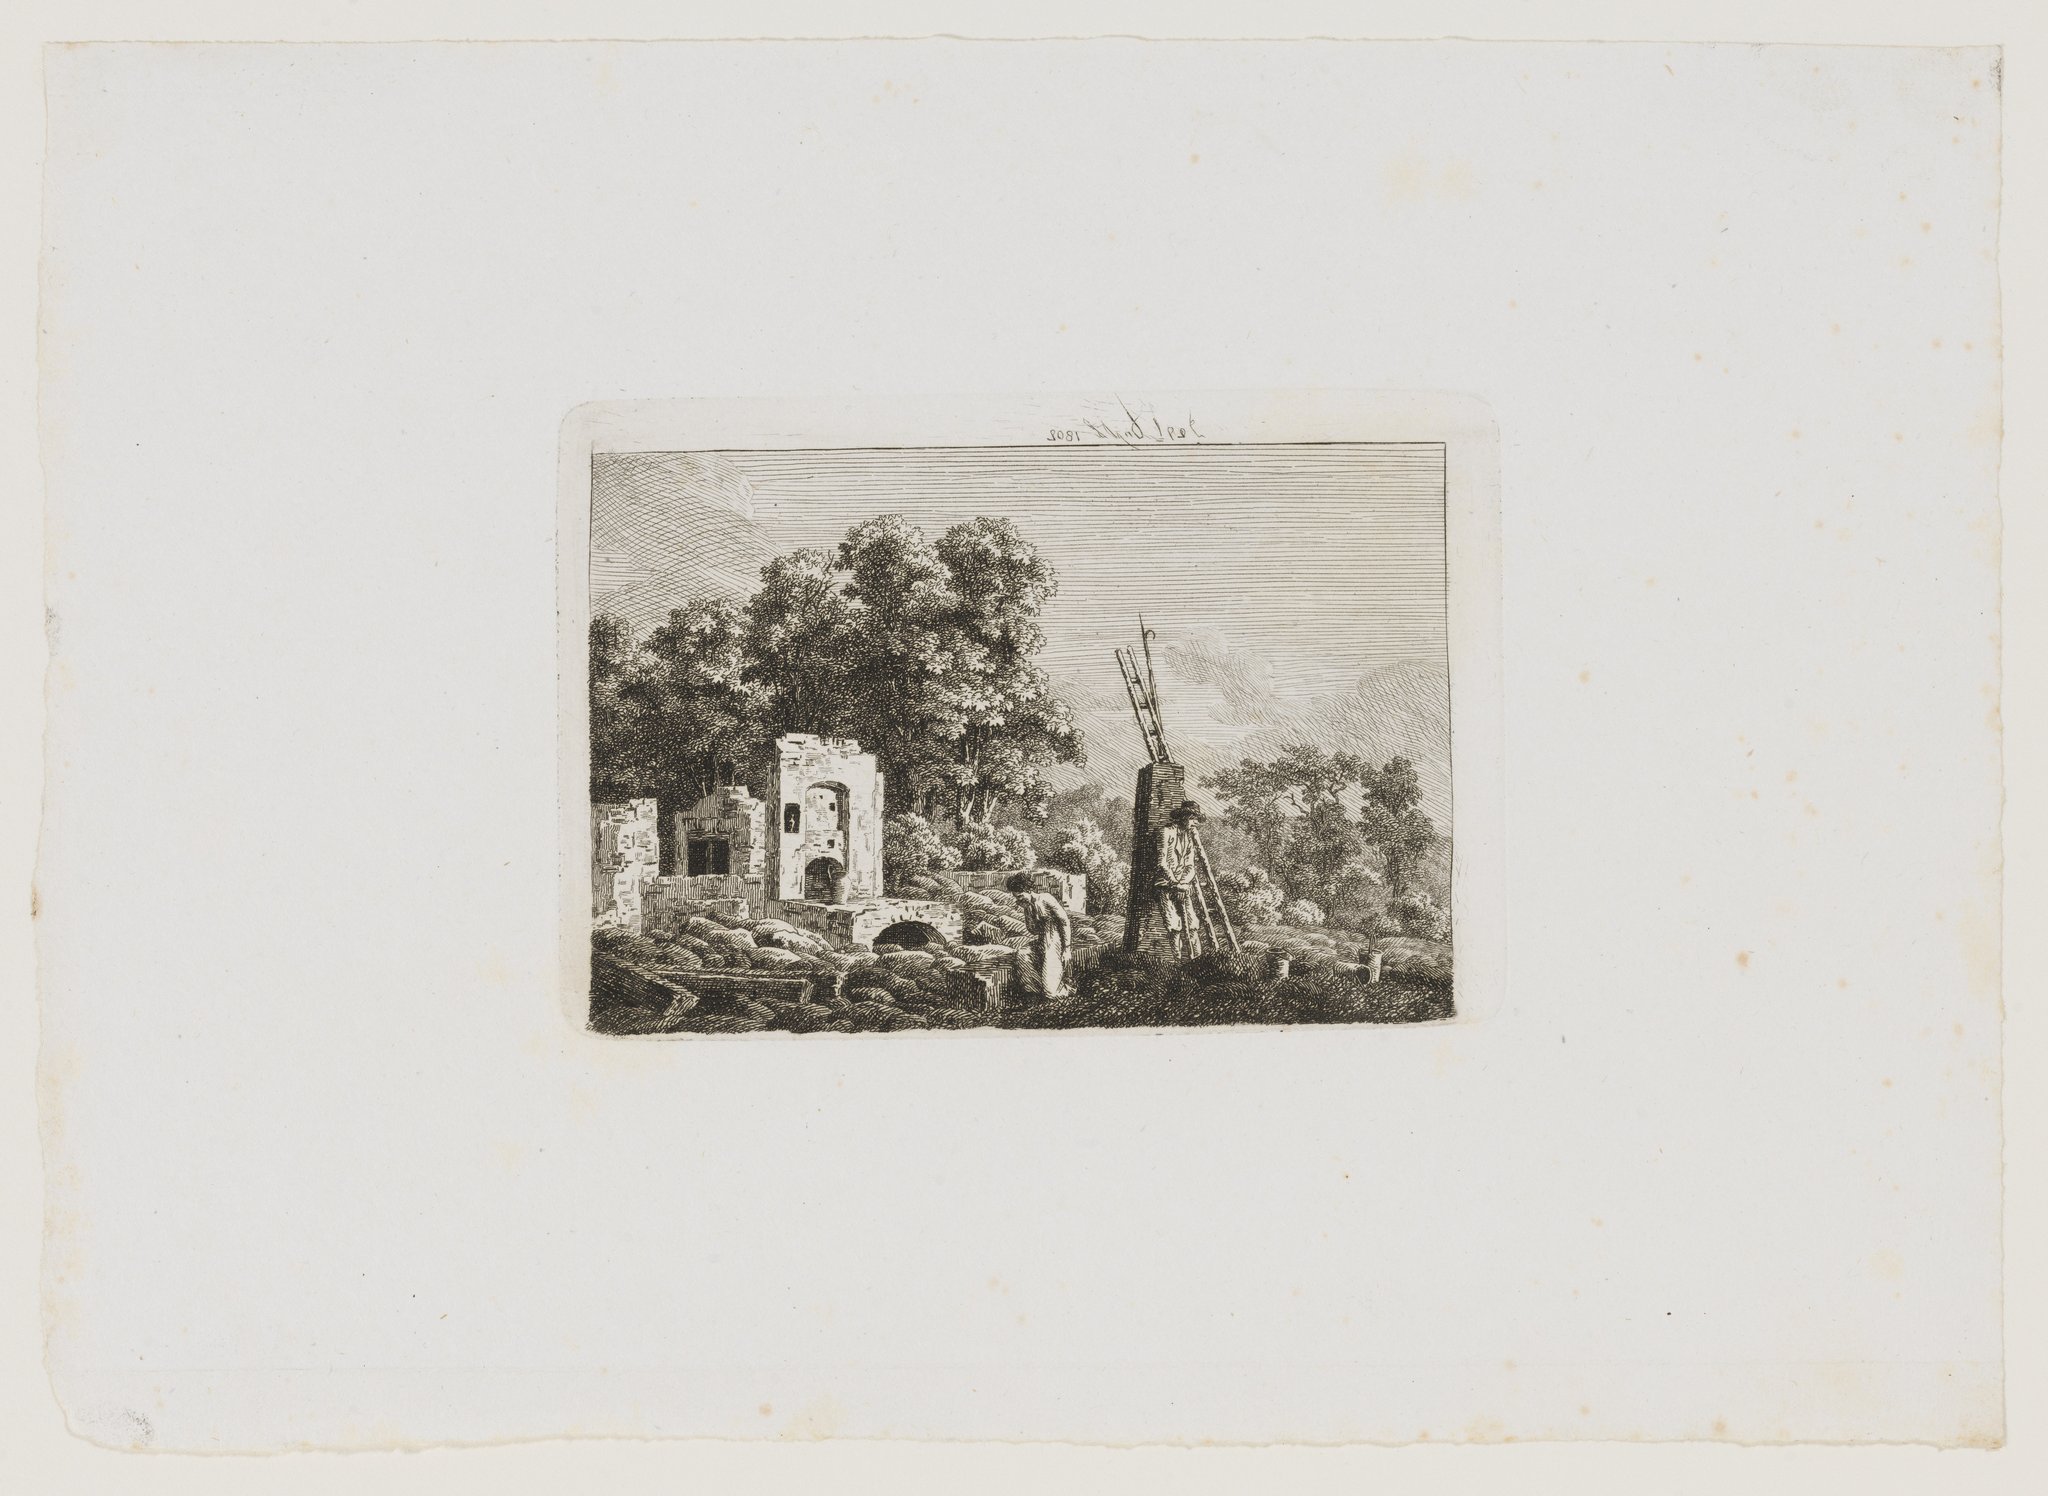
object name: print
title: Site of a Fire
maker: caspar david friedrich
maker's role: artist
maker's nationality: german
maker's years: 1774-1840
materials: paper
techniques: etching